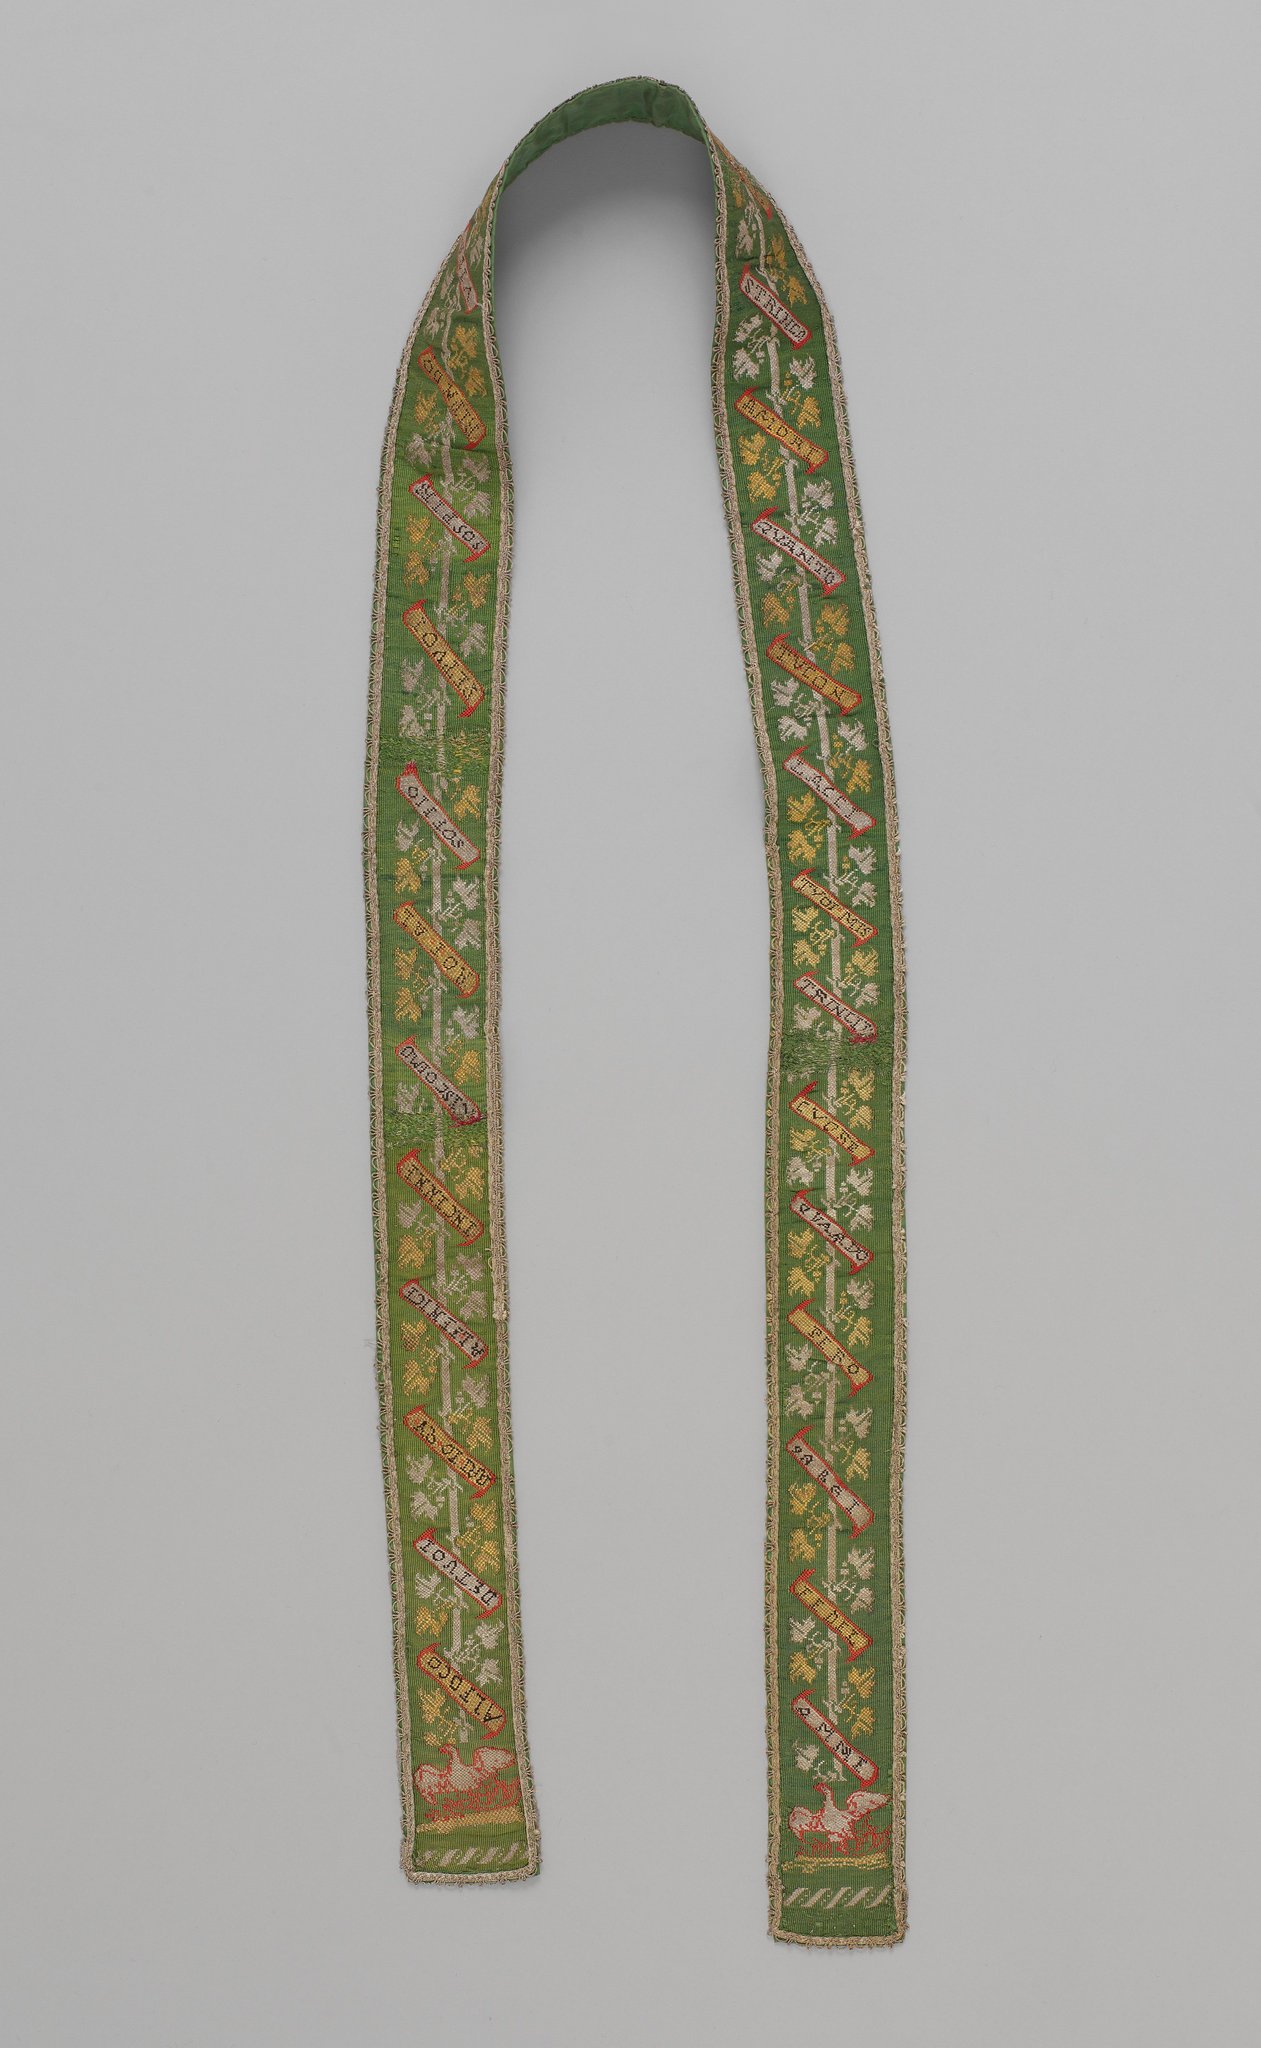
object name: belt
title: Belt or girdle with a woven love poem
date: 1501-1600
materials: metal thread, silk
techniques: weave